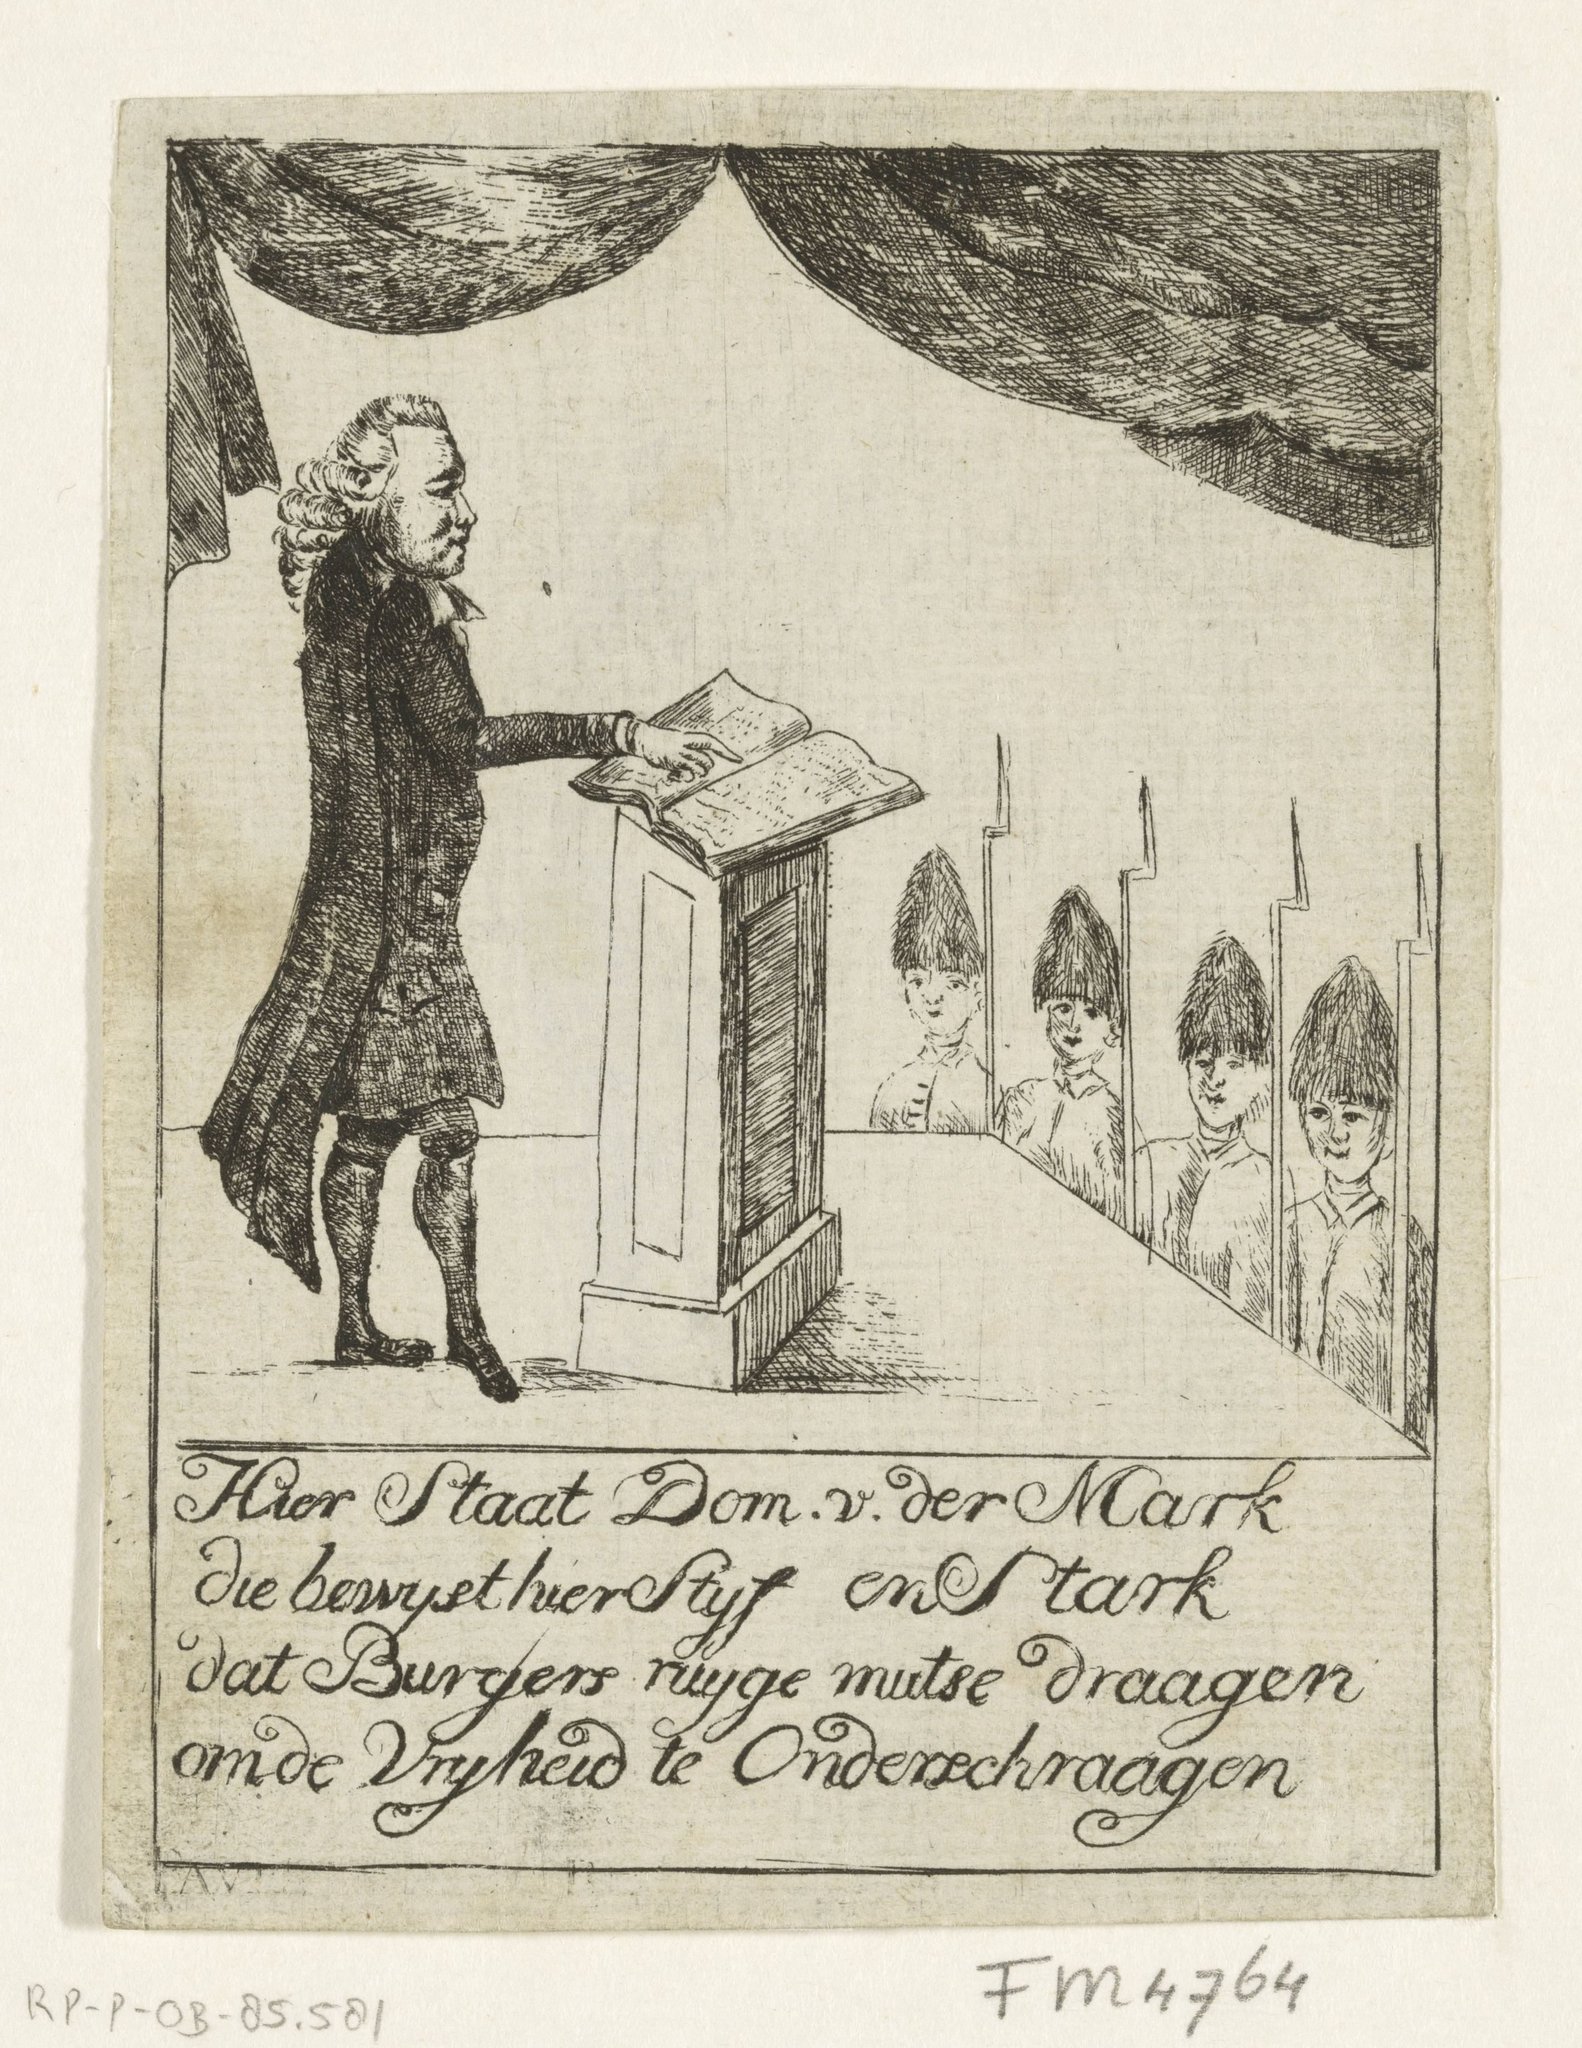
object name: print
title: Spotprent op de patriotse professor F.A. van der Marck, 1787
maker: Anonymous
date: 1787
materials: paper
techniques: engraving, etching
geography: northern netherlands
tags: lecture ~ university, scabrous scenes, pornography, deventer, patriots (1780-1795)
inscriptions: collector's mark: Lugt 2228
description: Spotprent op de patriotse professor Frederik Adolph van der Marck, die op 20 februari aan het hoofd van een burgercommissie te Deventer een nieuw reglement eiste. Van der Marck sprekend staande achter een katheder voor een groep soldaten. In het onderschrift een vers van vierregels. Transparant plaatje of doorkijkprent waarin een pornografische voorstelling zichtbaar wordt wanneer de prent tegen het licht wordt gehouden. Bij de prent behoort een pendant.